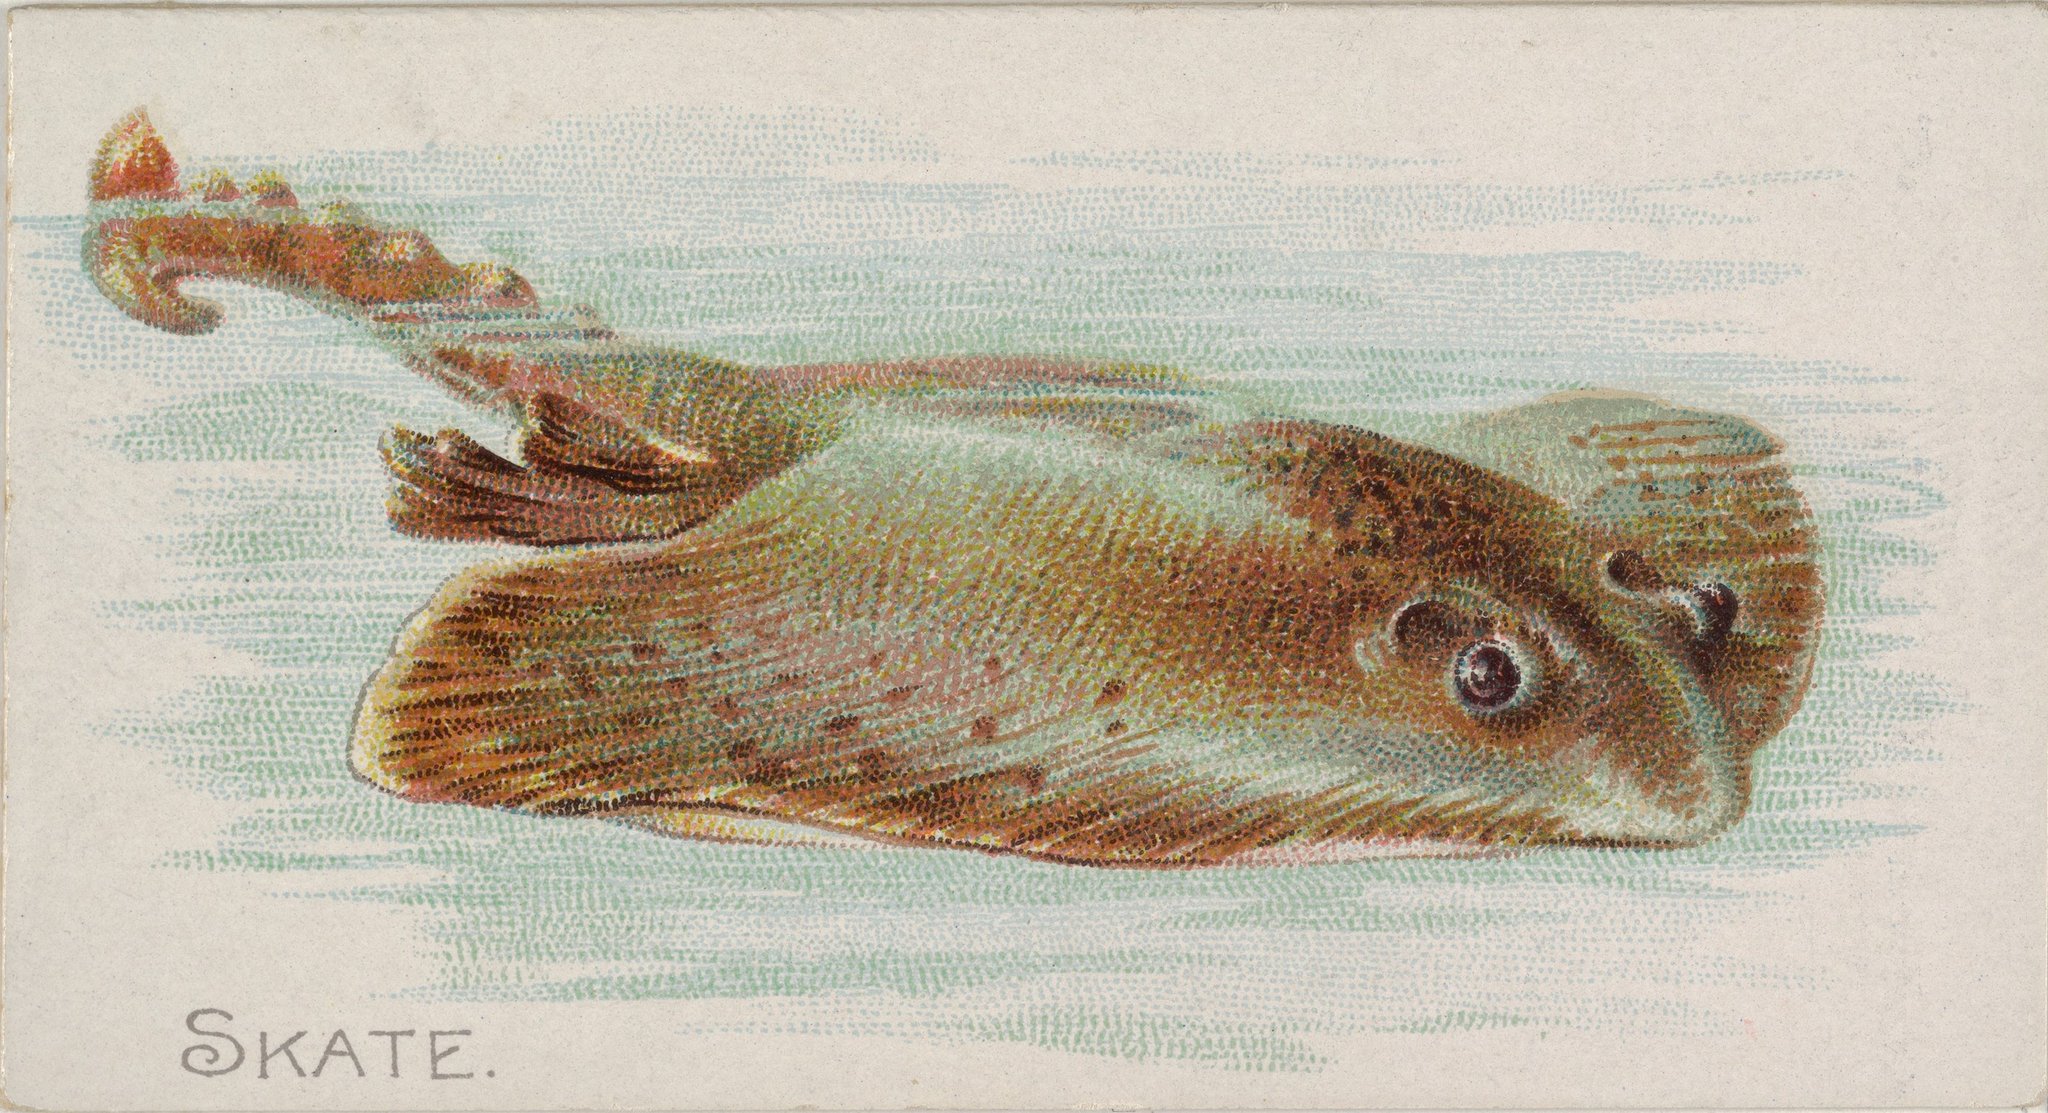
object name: print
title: Skate, from the Fish from American Waters series (N8) for Allen & Ginter Cigarettes Brands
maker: allen & ginter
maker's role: publisher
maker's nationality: american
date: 1889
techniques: color lithograph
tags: fish